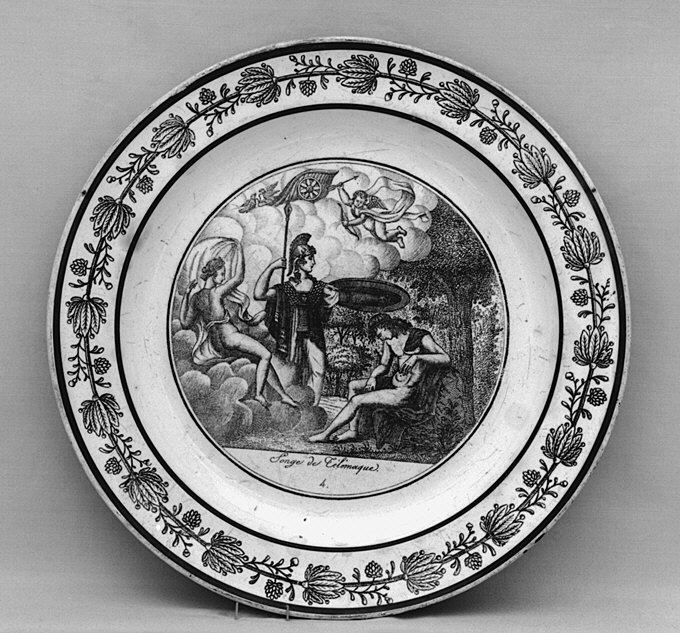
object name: plate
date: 1801-1900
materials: porcelain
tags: men,flowers,trees